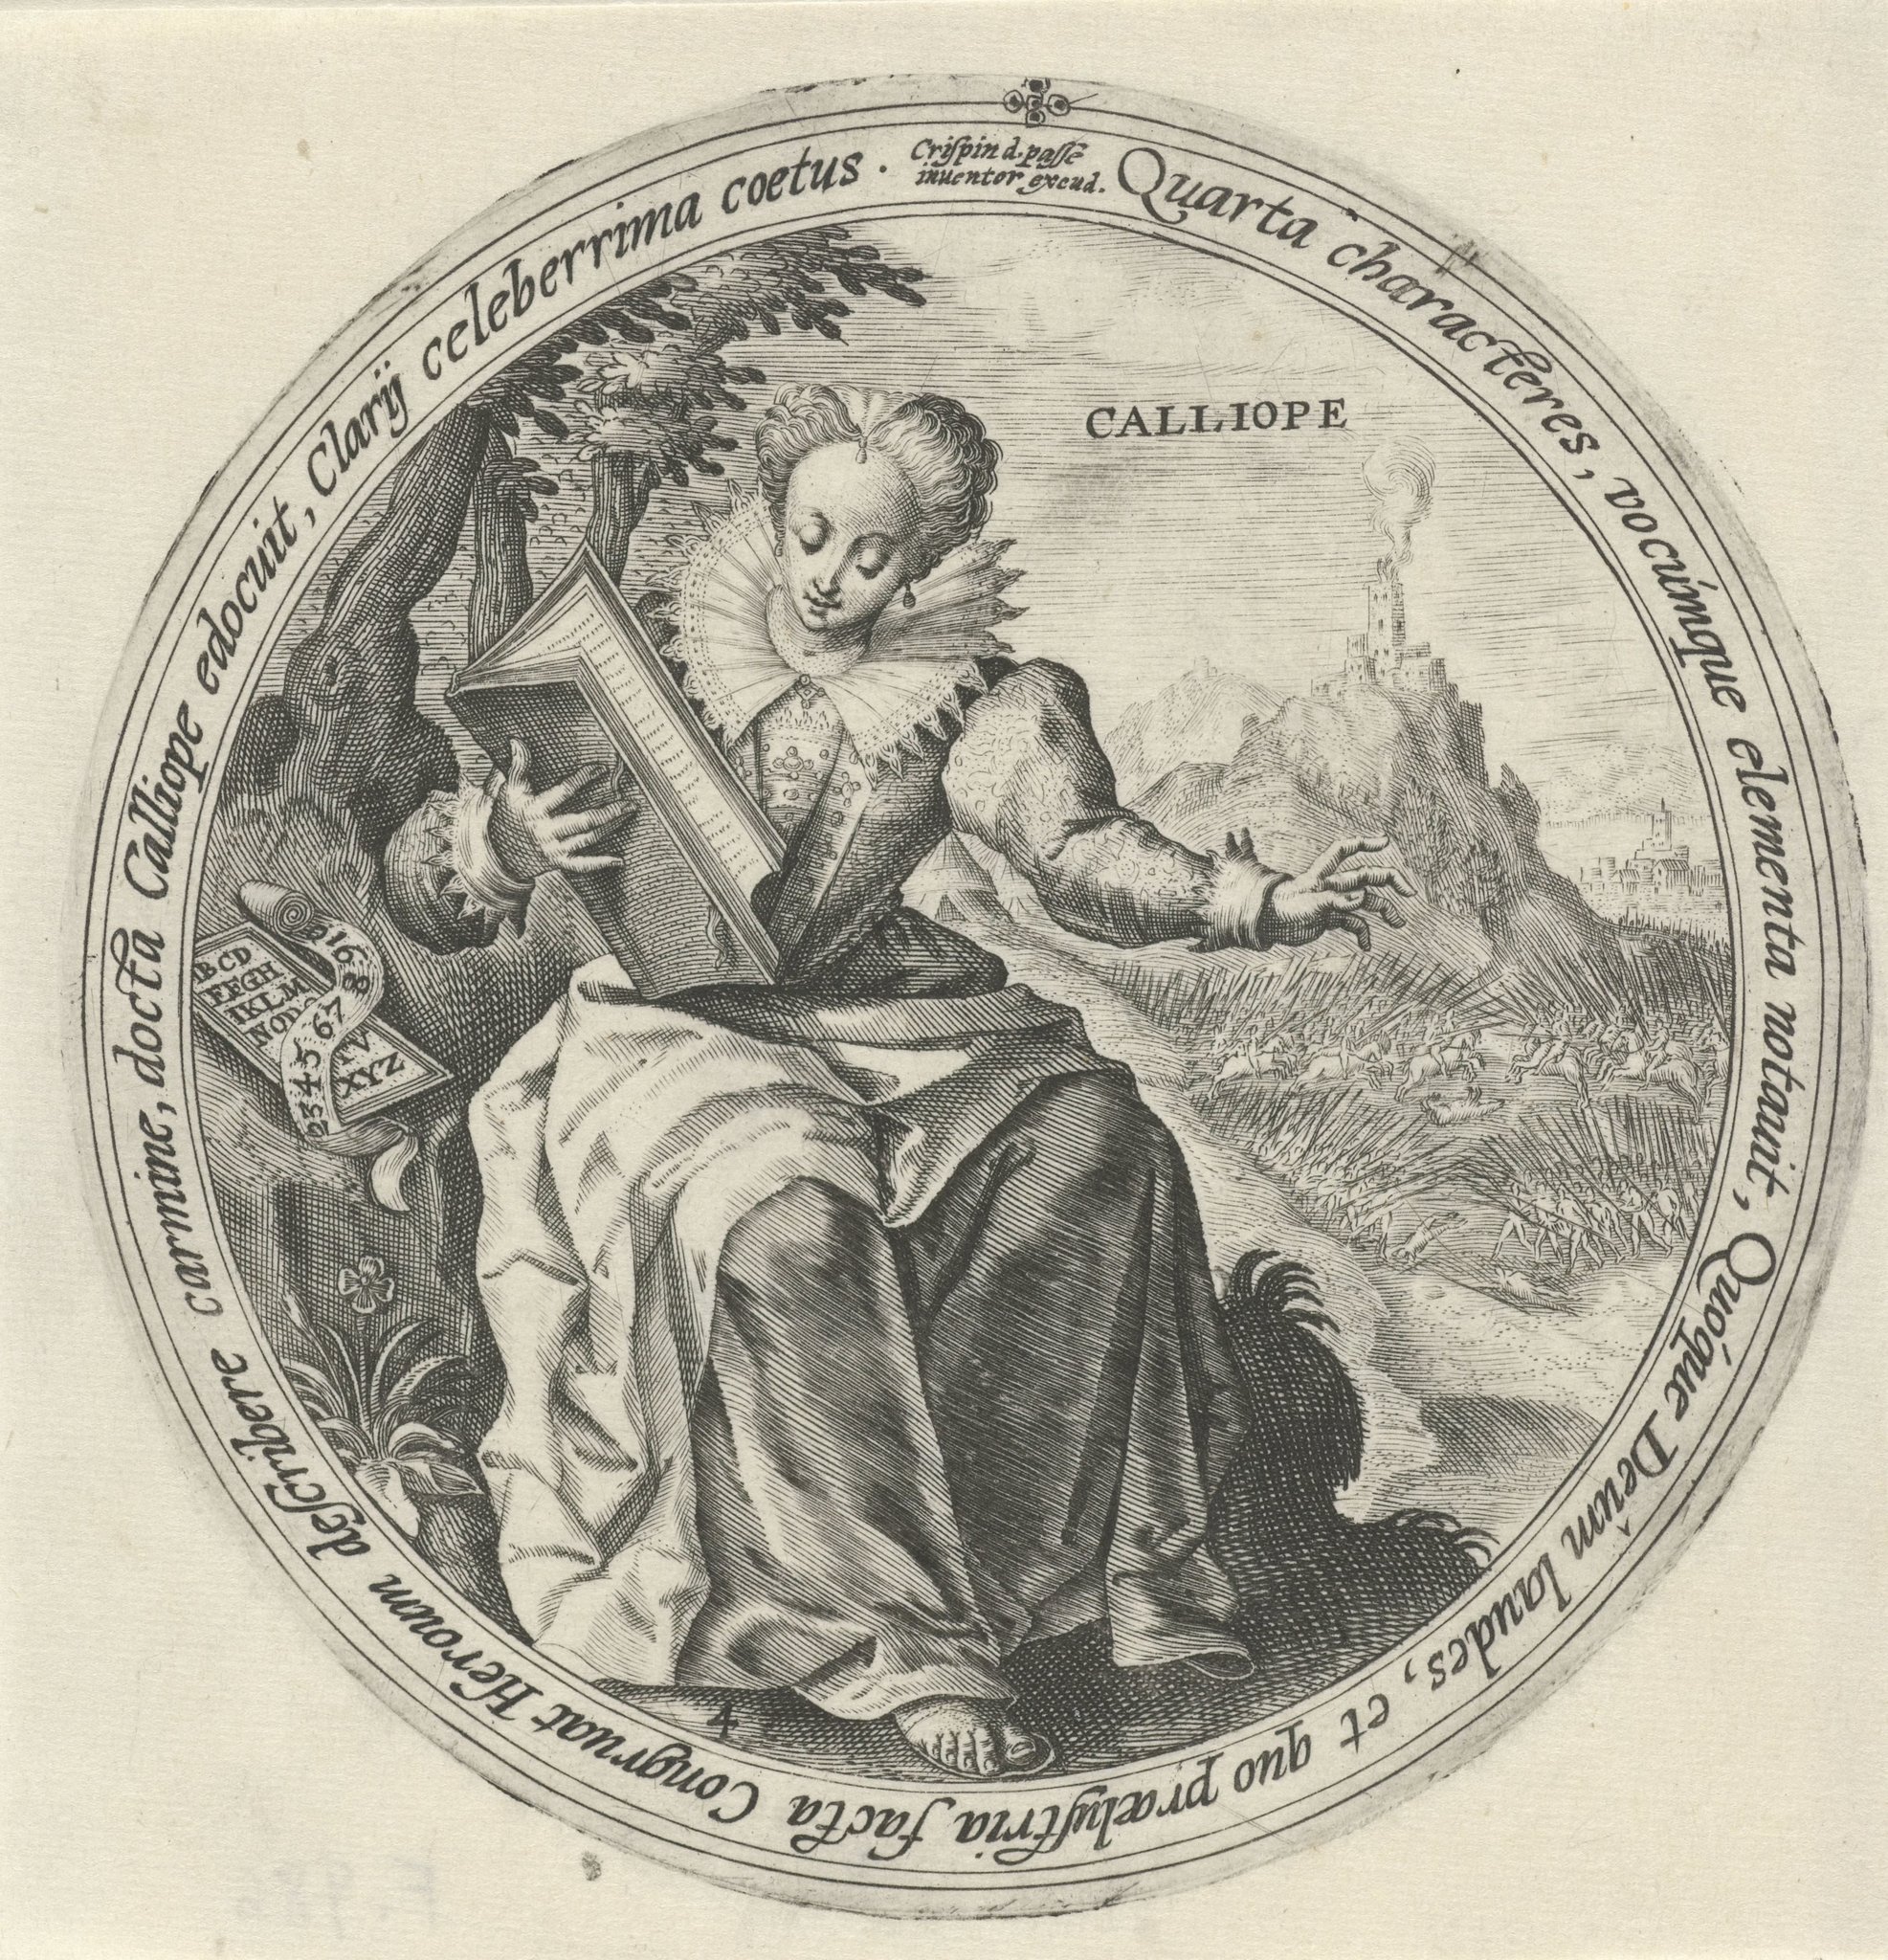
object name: print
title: De negen muzen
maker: crispijn van de passe (i)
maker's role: draughtsman, print maker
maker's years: 1564-1637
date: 1589-1611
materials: paper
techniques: engraving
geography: cologne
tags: calliope (one of the muses); 'calliope' (ripa), assault ~ siege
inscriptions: collector's mark: Lugt 2228, collector's mark: Lugt 2760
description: Landschap met Calliope, de muze van de epiek, met een opengeslagen boek op haar schoot. Op de achtergrond een veldslag. Vierde prent uit een serie met muzen.